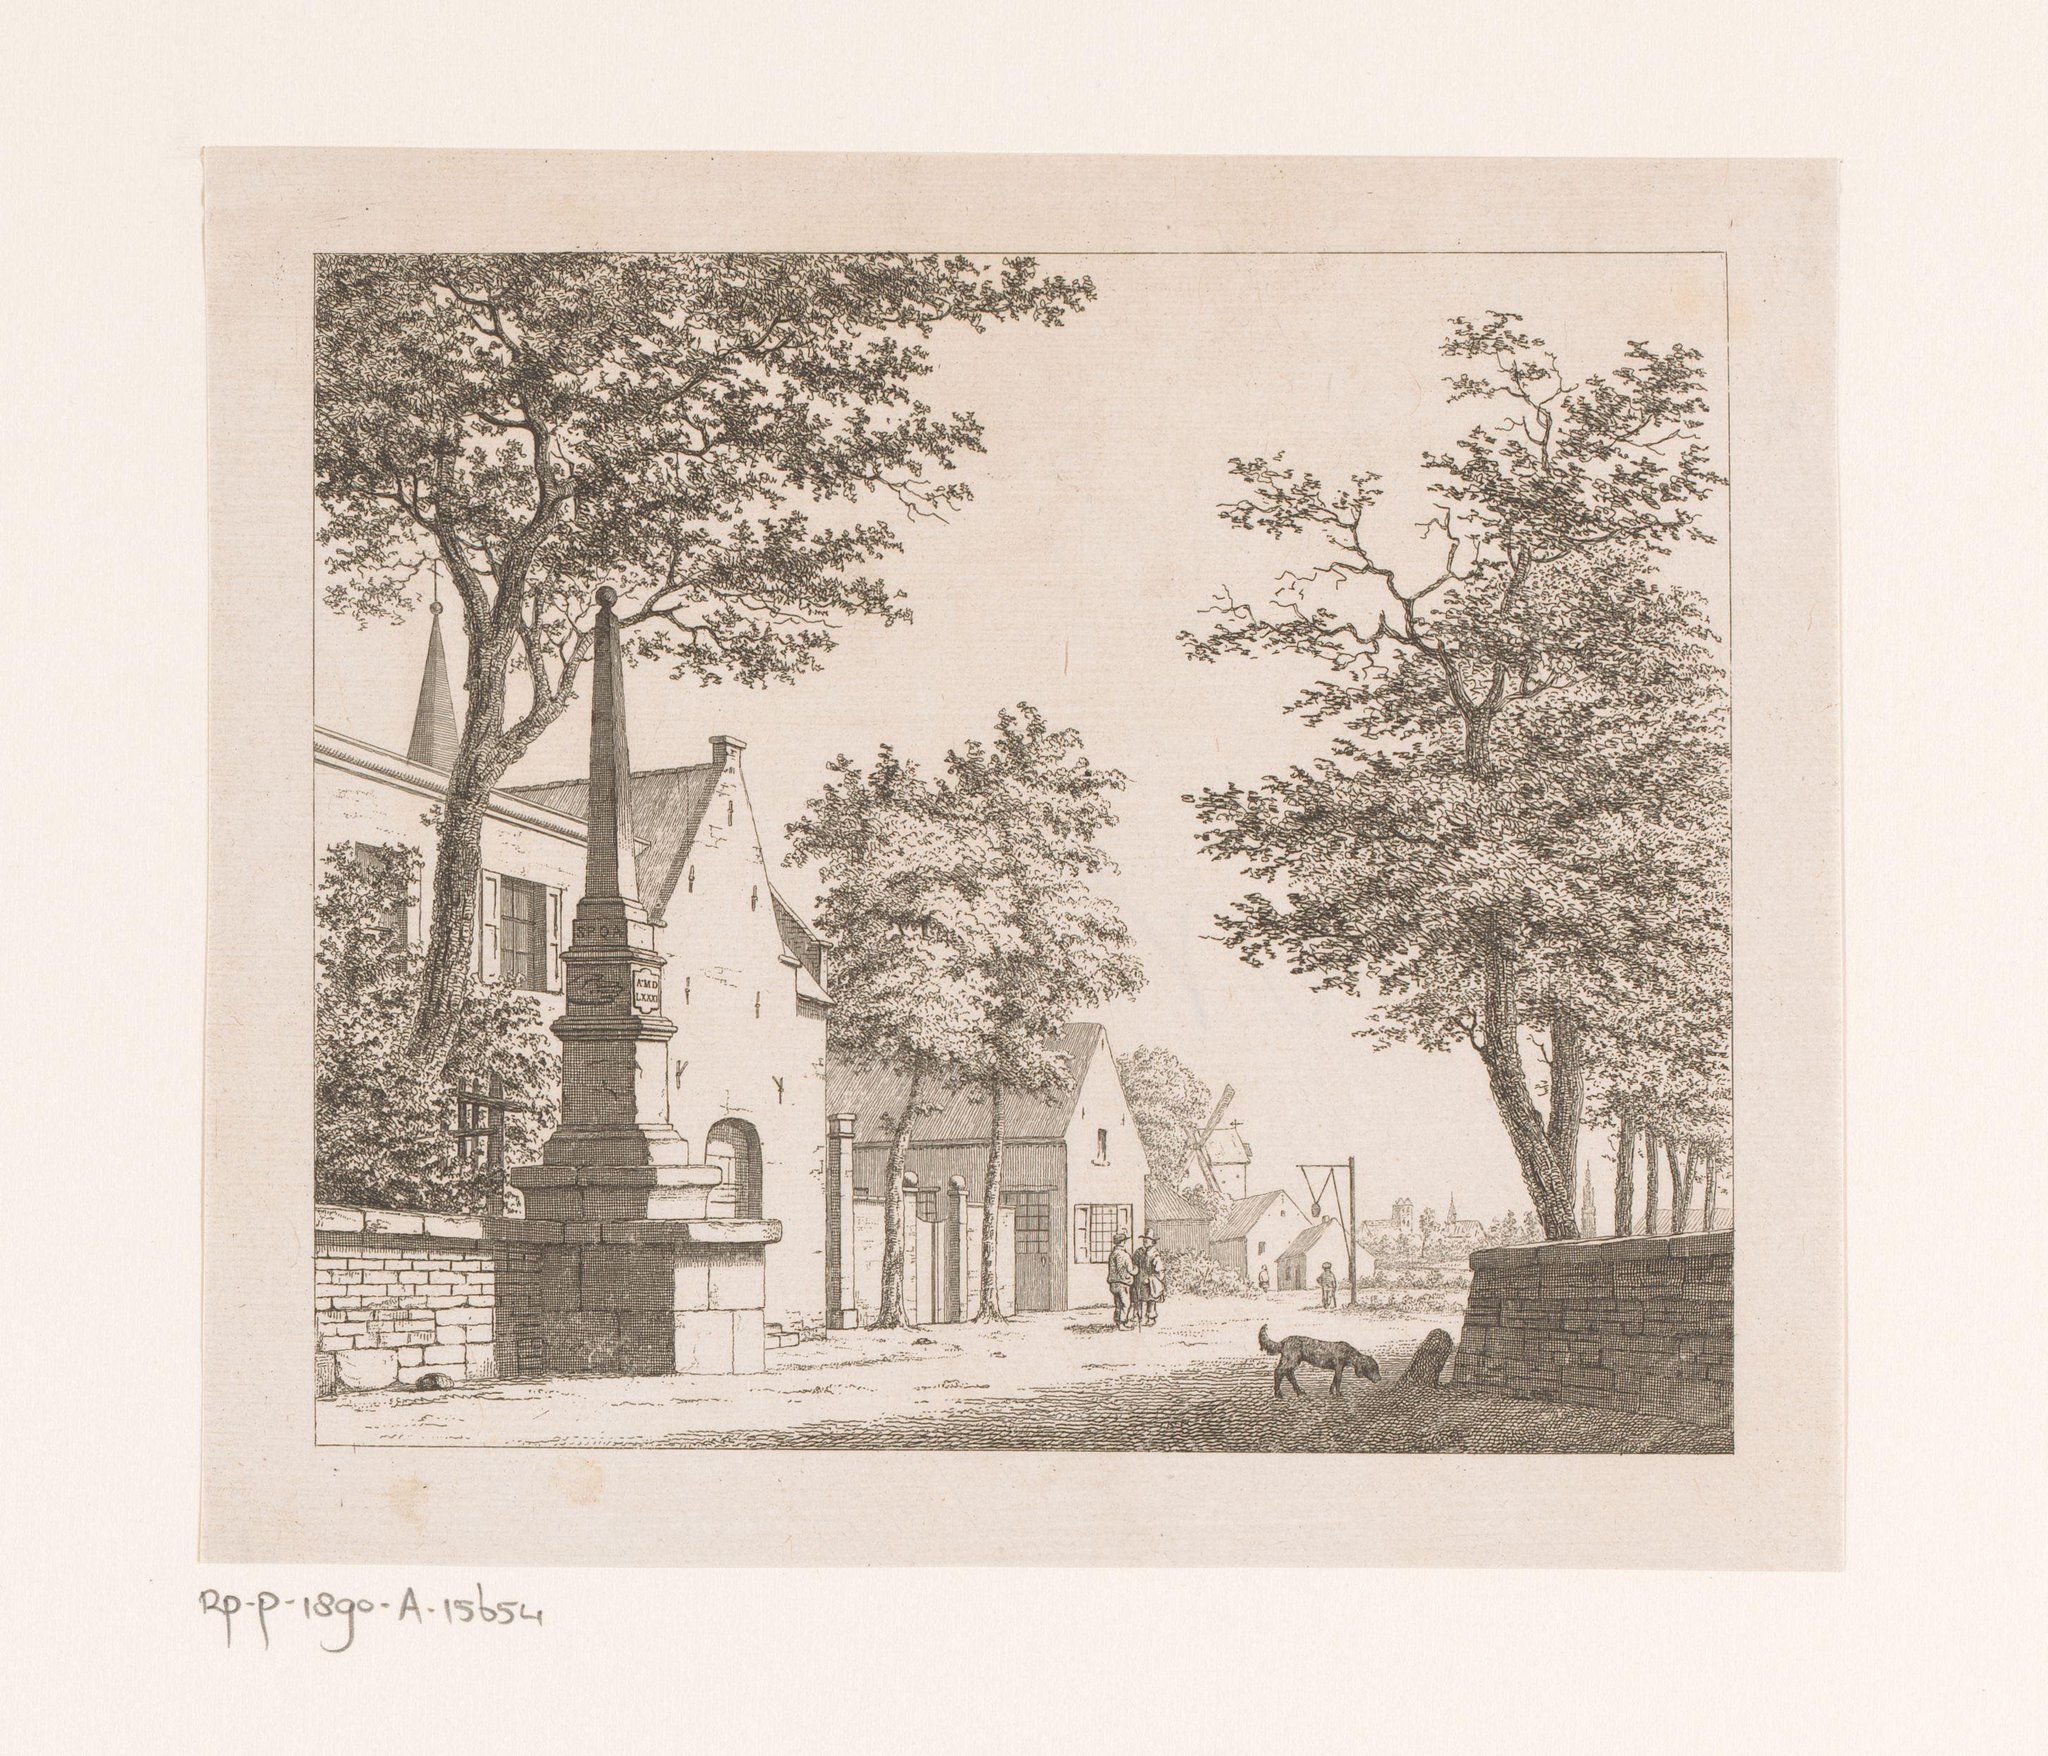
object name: print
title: Grenspaal van Antwerpse jurisdictie in Dambrugge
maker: jean théodore joseph linnig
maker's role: draughtsman, print maker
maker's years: 1815-1891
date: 1849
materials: paper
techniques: etching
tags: boundary-post, boundary-stone, antwerp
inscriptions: collector's mark: Lugt 2228